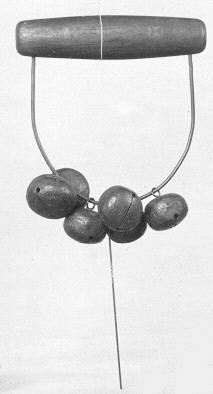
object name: zichirei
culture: japanese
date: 1801-1900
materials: metal, wood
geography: japan